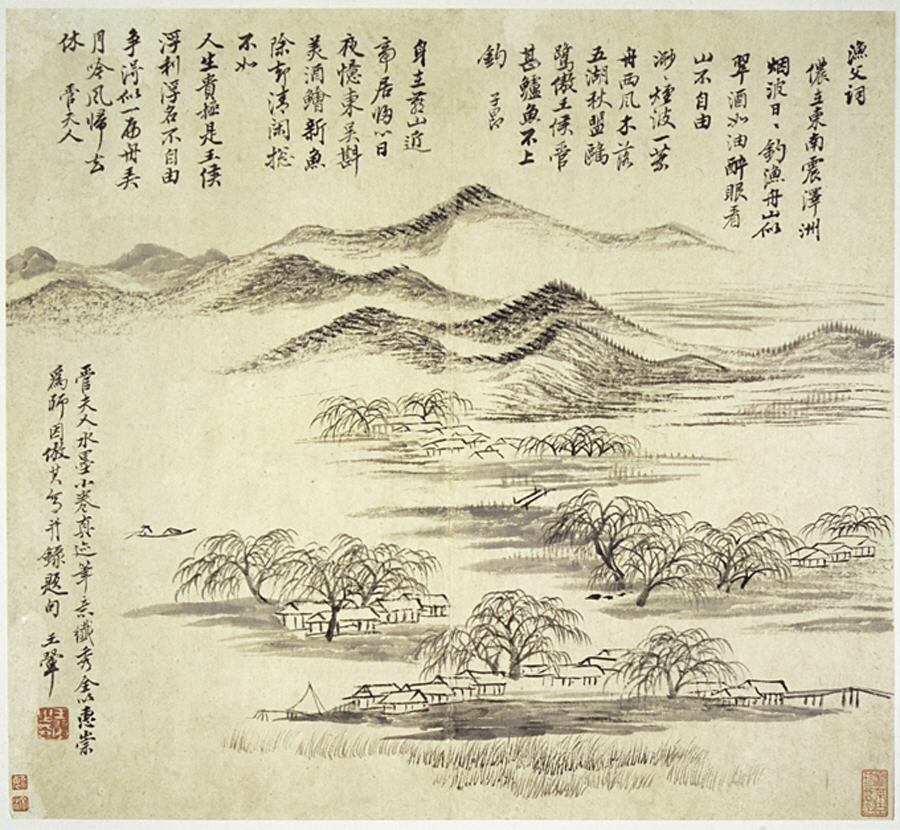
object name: album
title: Landscapes after old masters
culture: chinese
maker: wang hui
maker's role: artist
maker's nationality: chinese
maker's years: 1632-1717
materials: ink, paper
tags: mountains,landscapes